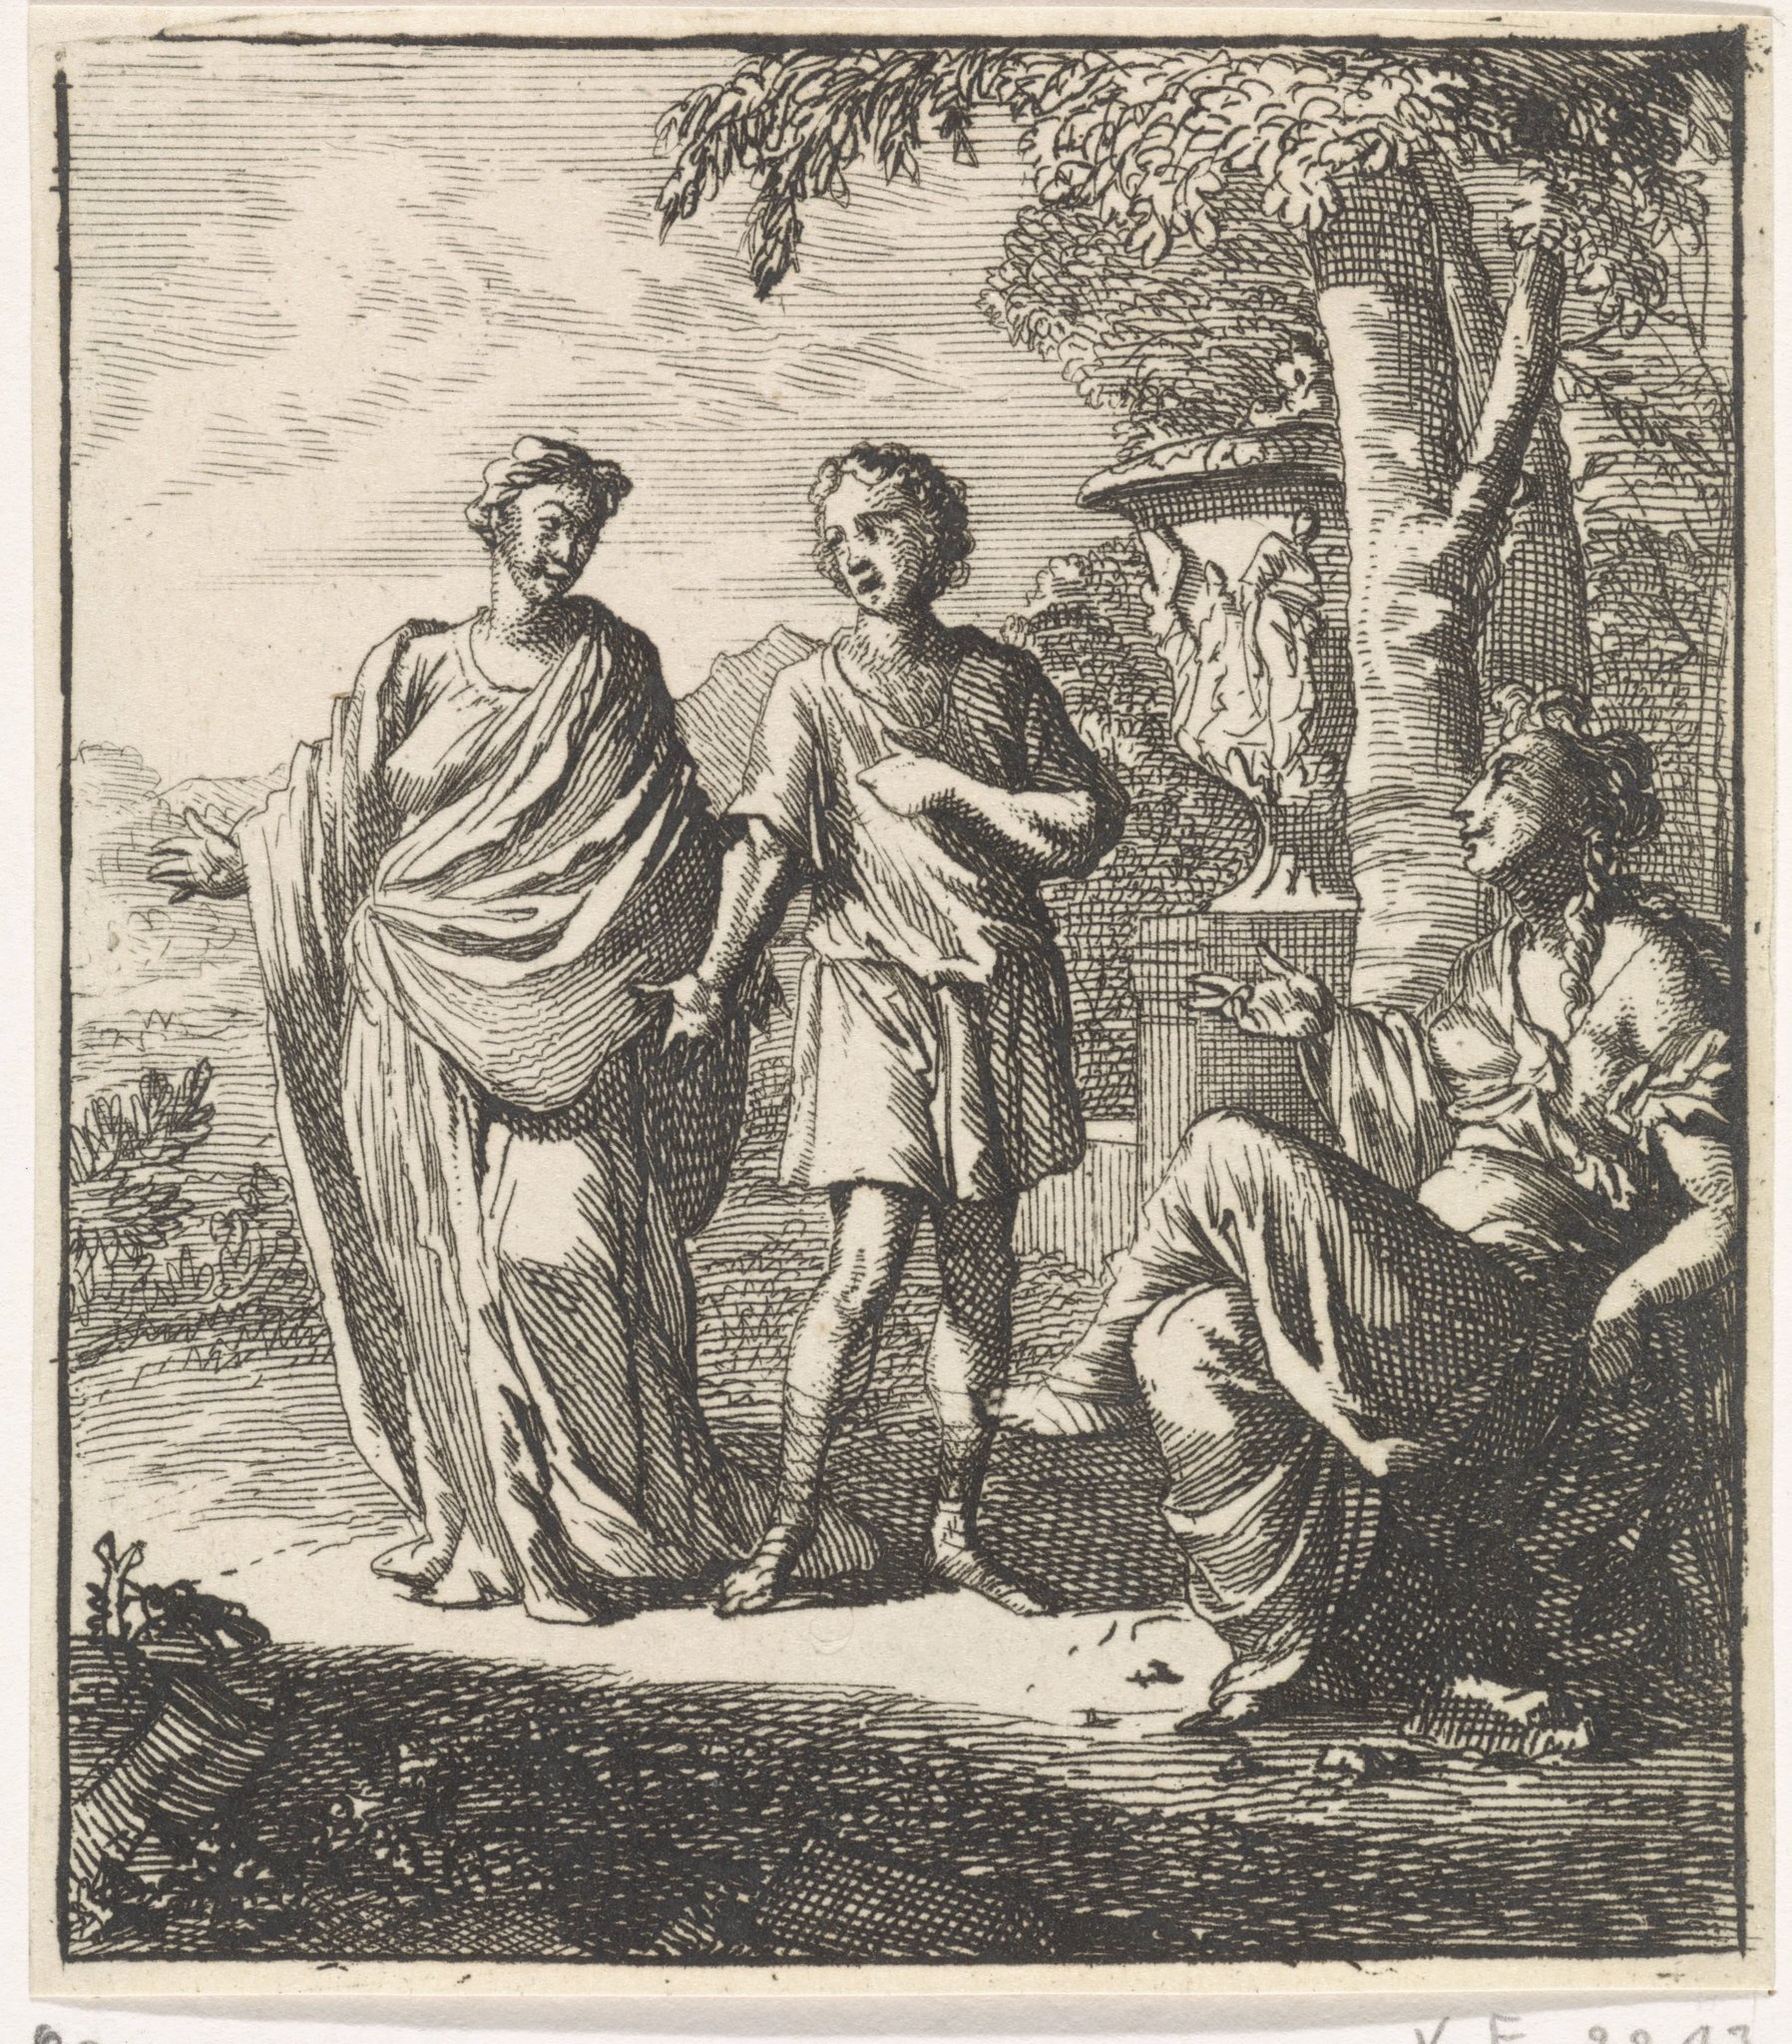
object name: book illustration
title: Jongeling tussen Deugd en Wellust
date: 1699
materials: paper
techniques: etching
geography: amsterdam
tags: one virtue vs. figure representing a vice, lust, luxury, 'luxuria'; 'lussuria' (ripa) ~ personification of one of the deadly sins, distinction between good and bad; 'distintione del bene & del male' (ripa)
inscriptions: collector's mark: Lugt 2228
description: Een jongeling staat tussen twee vrouwen. Links staat de personificatie Deugd in een lang gewaad. Rechts zit de verleidelijke personificatie Wellust. Beide proberen hem over te halen.